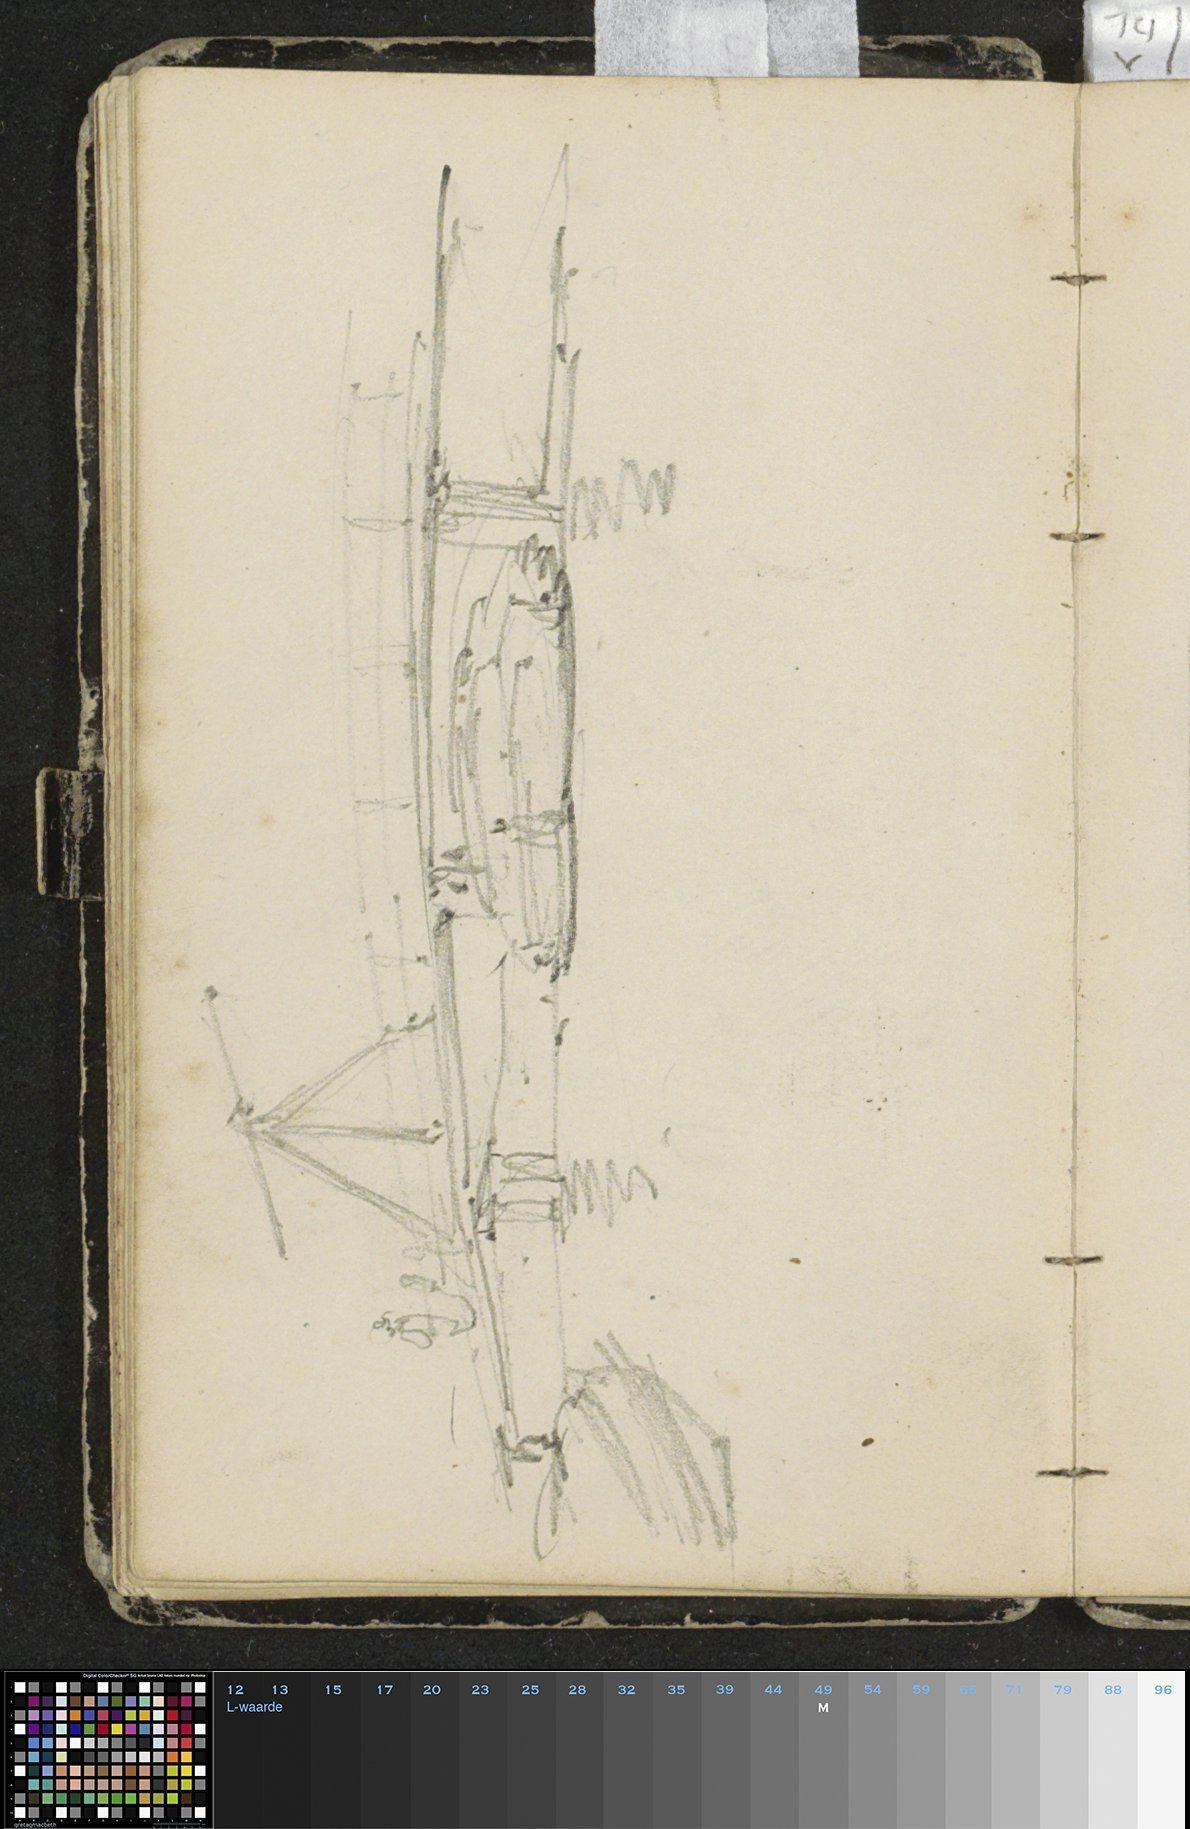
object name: sketchbook leaf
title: Boot varend bij een brug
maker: willem koekkoek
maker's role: draughtsman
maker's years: 1839-1895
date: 1849-1895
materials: paper, pencil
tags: bridge, traffic on the water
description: Blad 11 verso uit een schetsboek met 57 bladen.